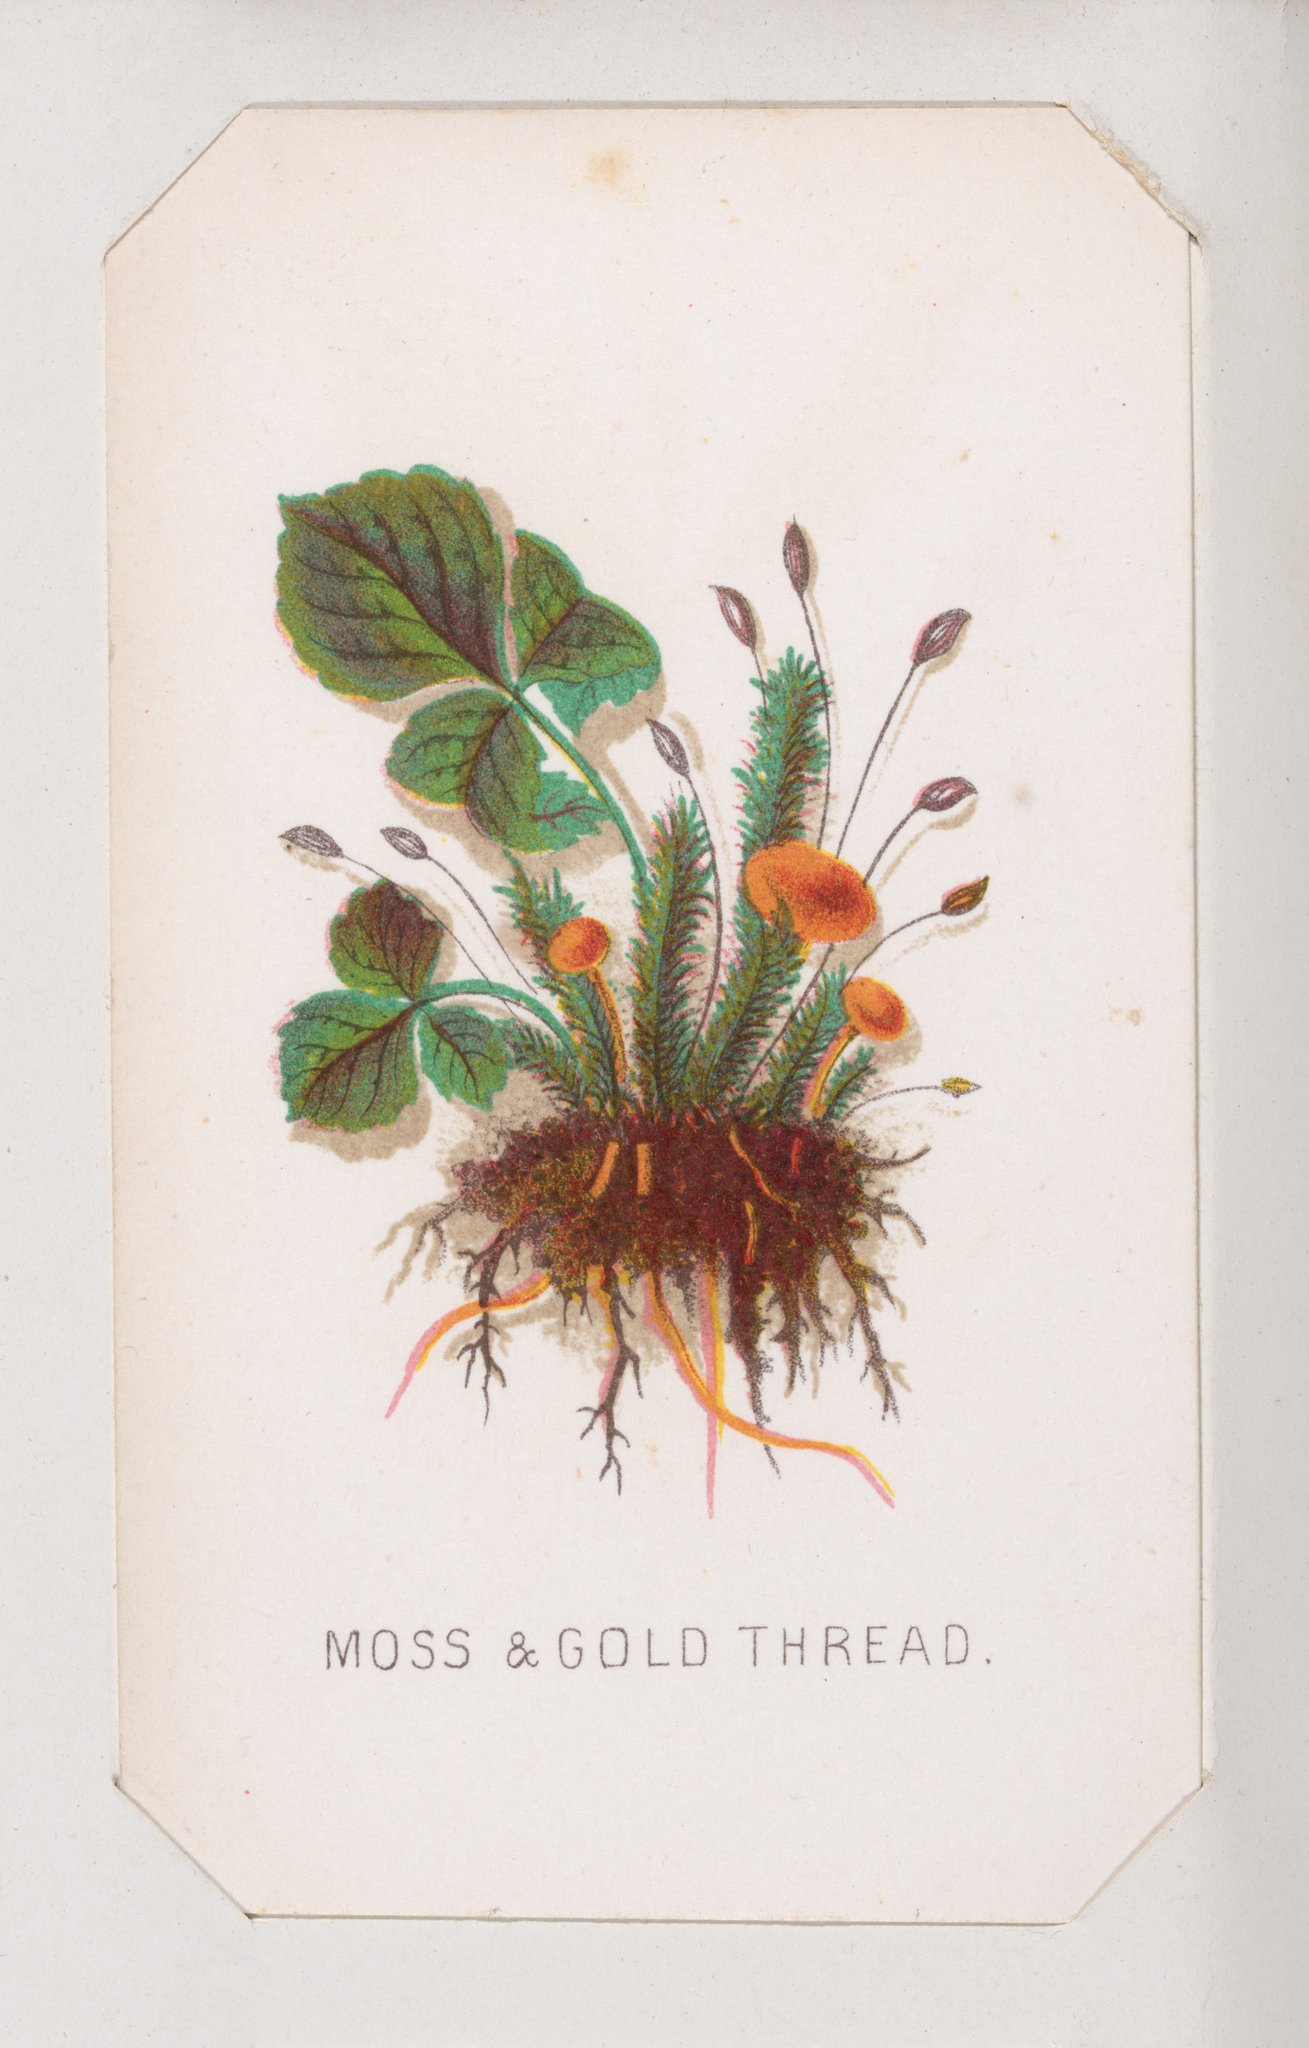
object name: album card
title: Moss & Gold Thread card from the Plant with Root series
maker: louis prang & co.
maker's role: publisher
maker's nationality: american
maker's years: 1800-1950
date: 1862-1869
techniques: lithograph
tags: plants